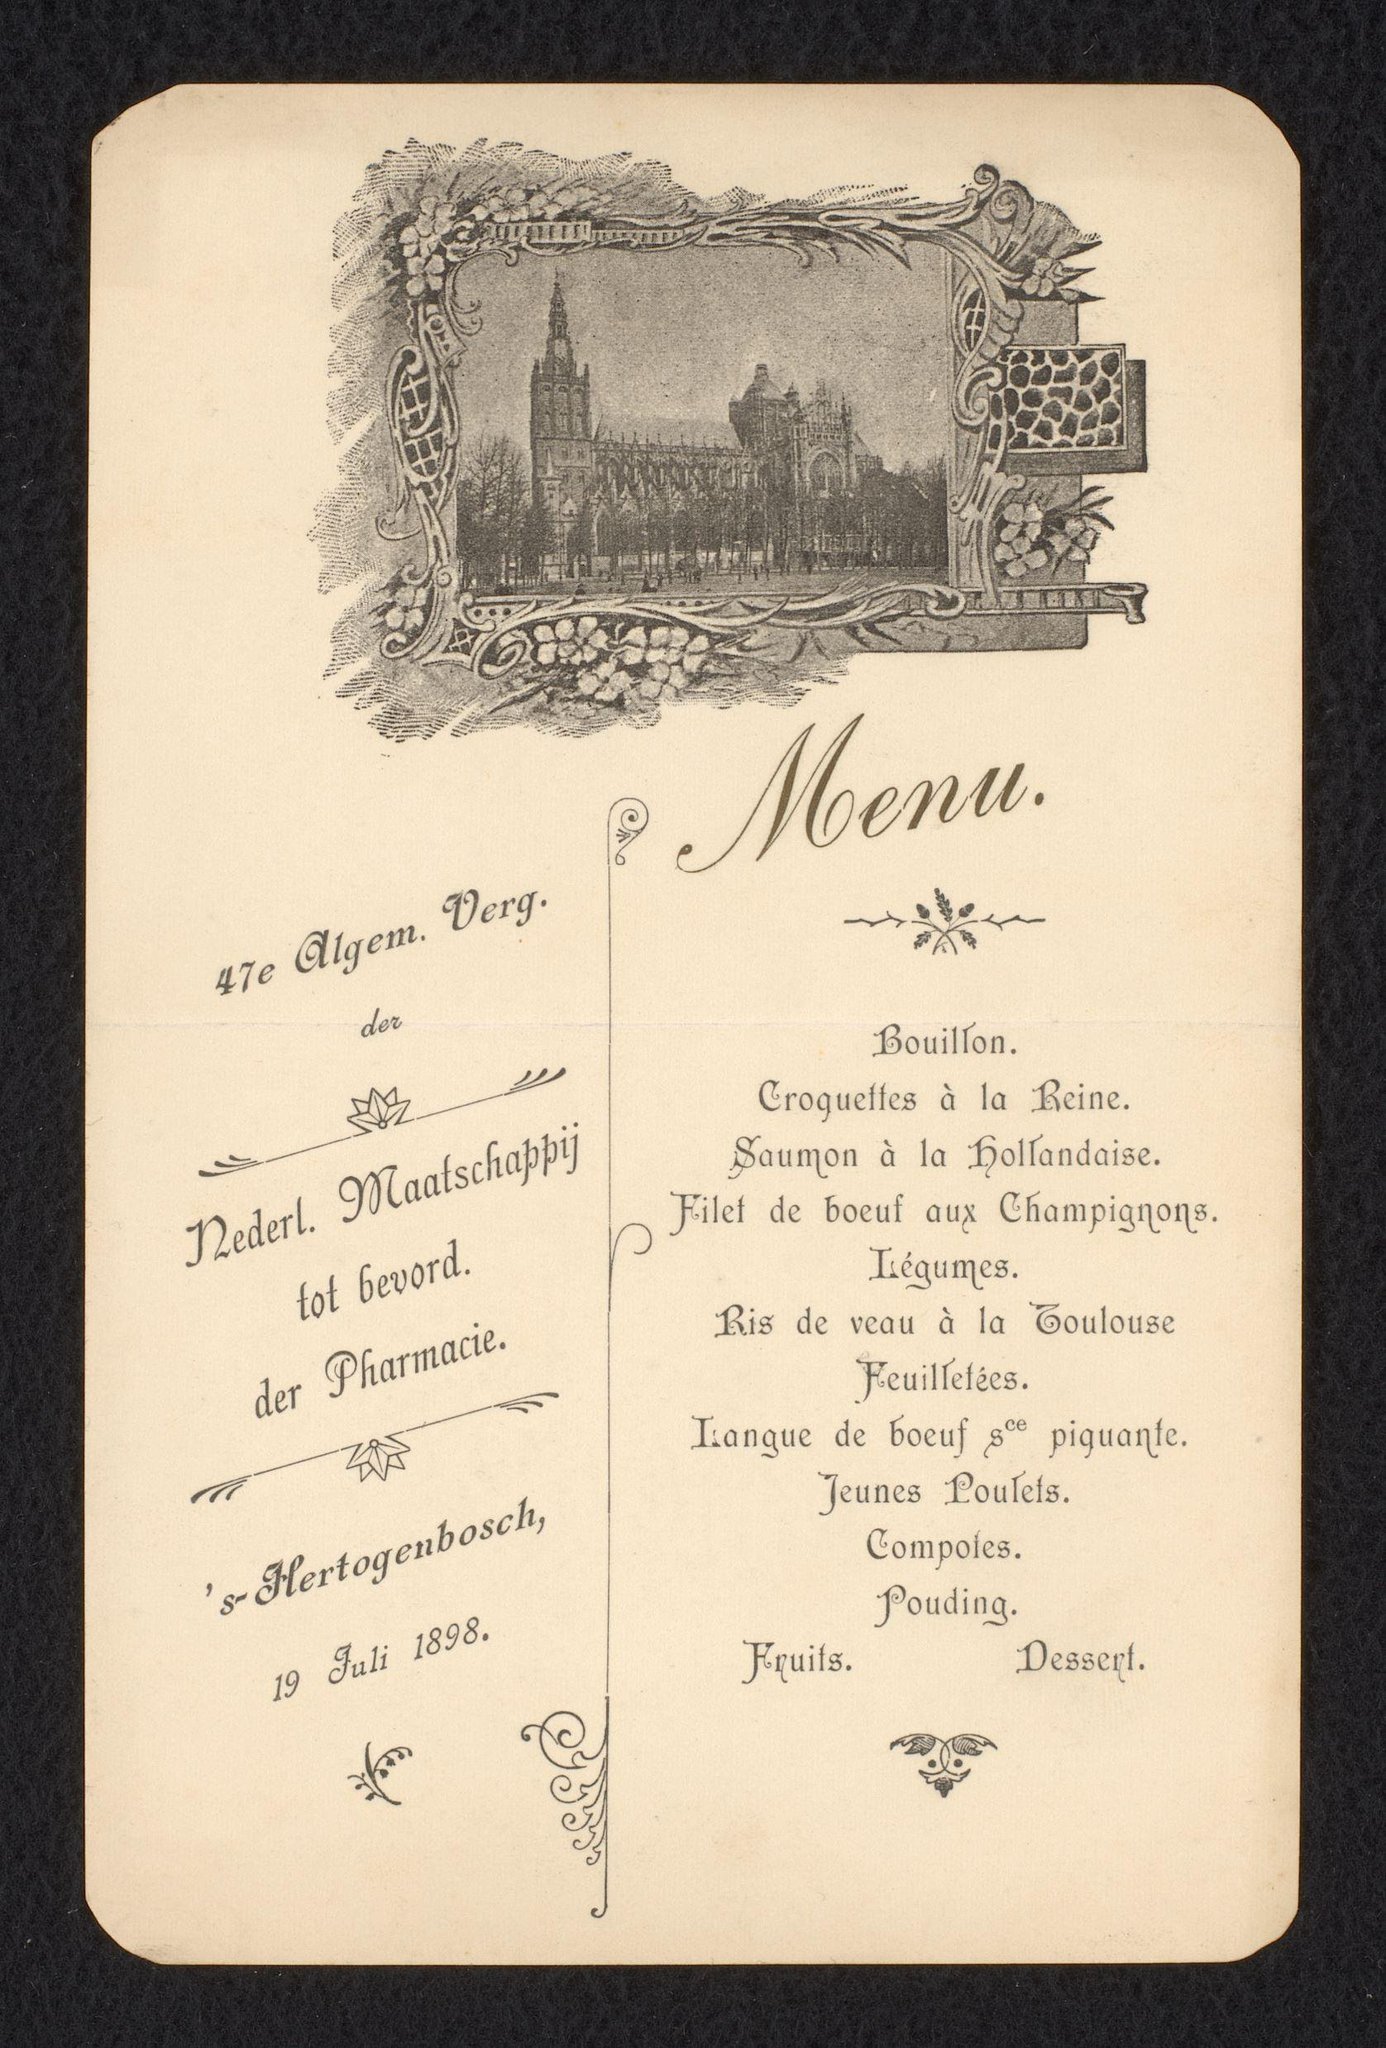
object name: menu, menukaart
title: Menukaart voor het diner van de 47e Algemene Vergadering van de Nederlandse Maatschappij tot Bevordering der Pharmacie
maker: Anonymous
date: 1898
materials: paper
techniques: letterpress printing, offset printed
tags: church (exterior), den bosch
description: Bovenaan, in een decoratief kader, de Sint-Janskathedraal van Den Bosch. Daaronder het menu en details over het diner, dat op 19 juli 1898 plaatsvond in Den Bosch.